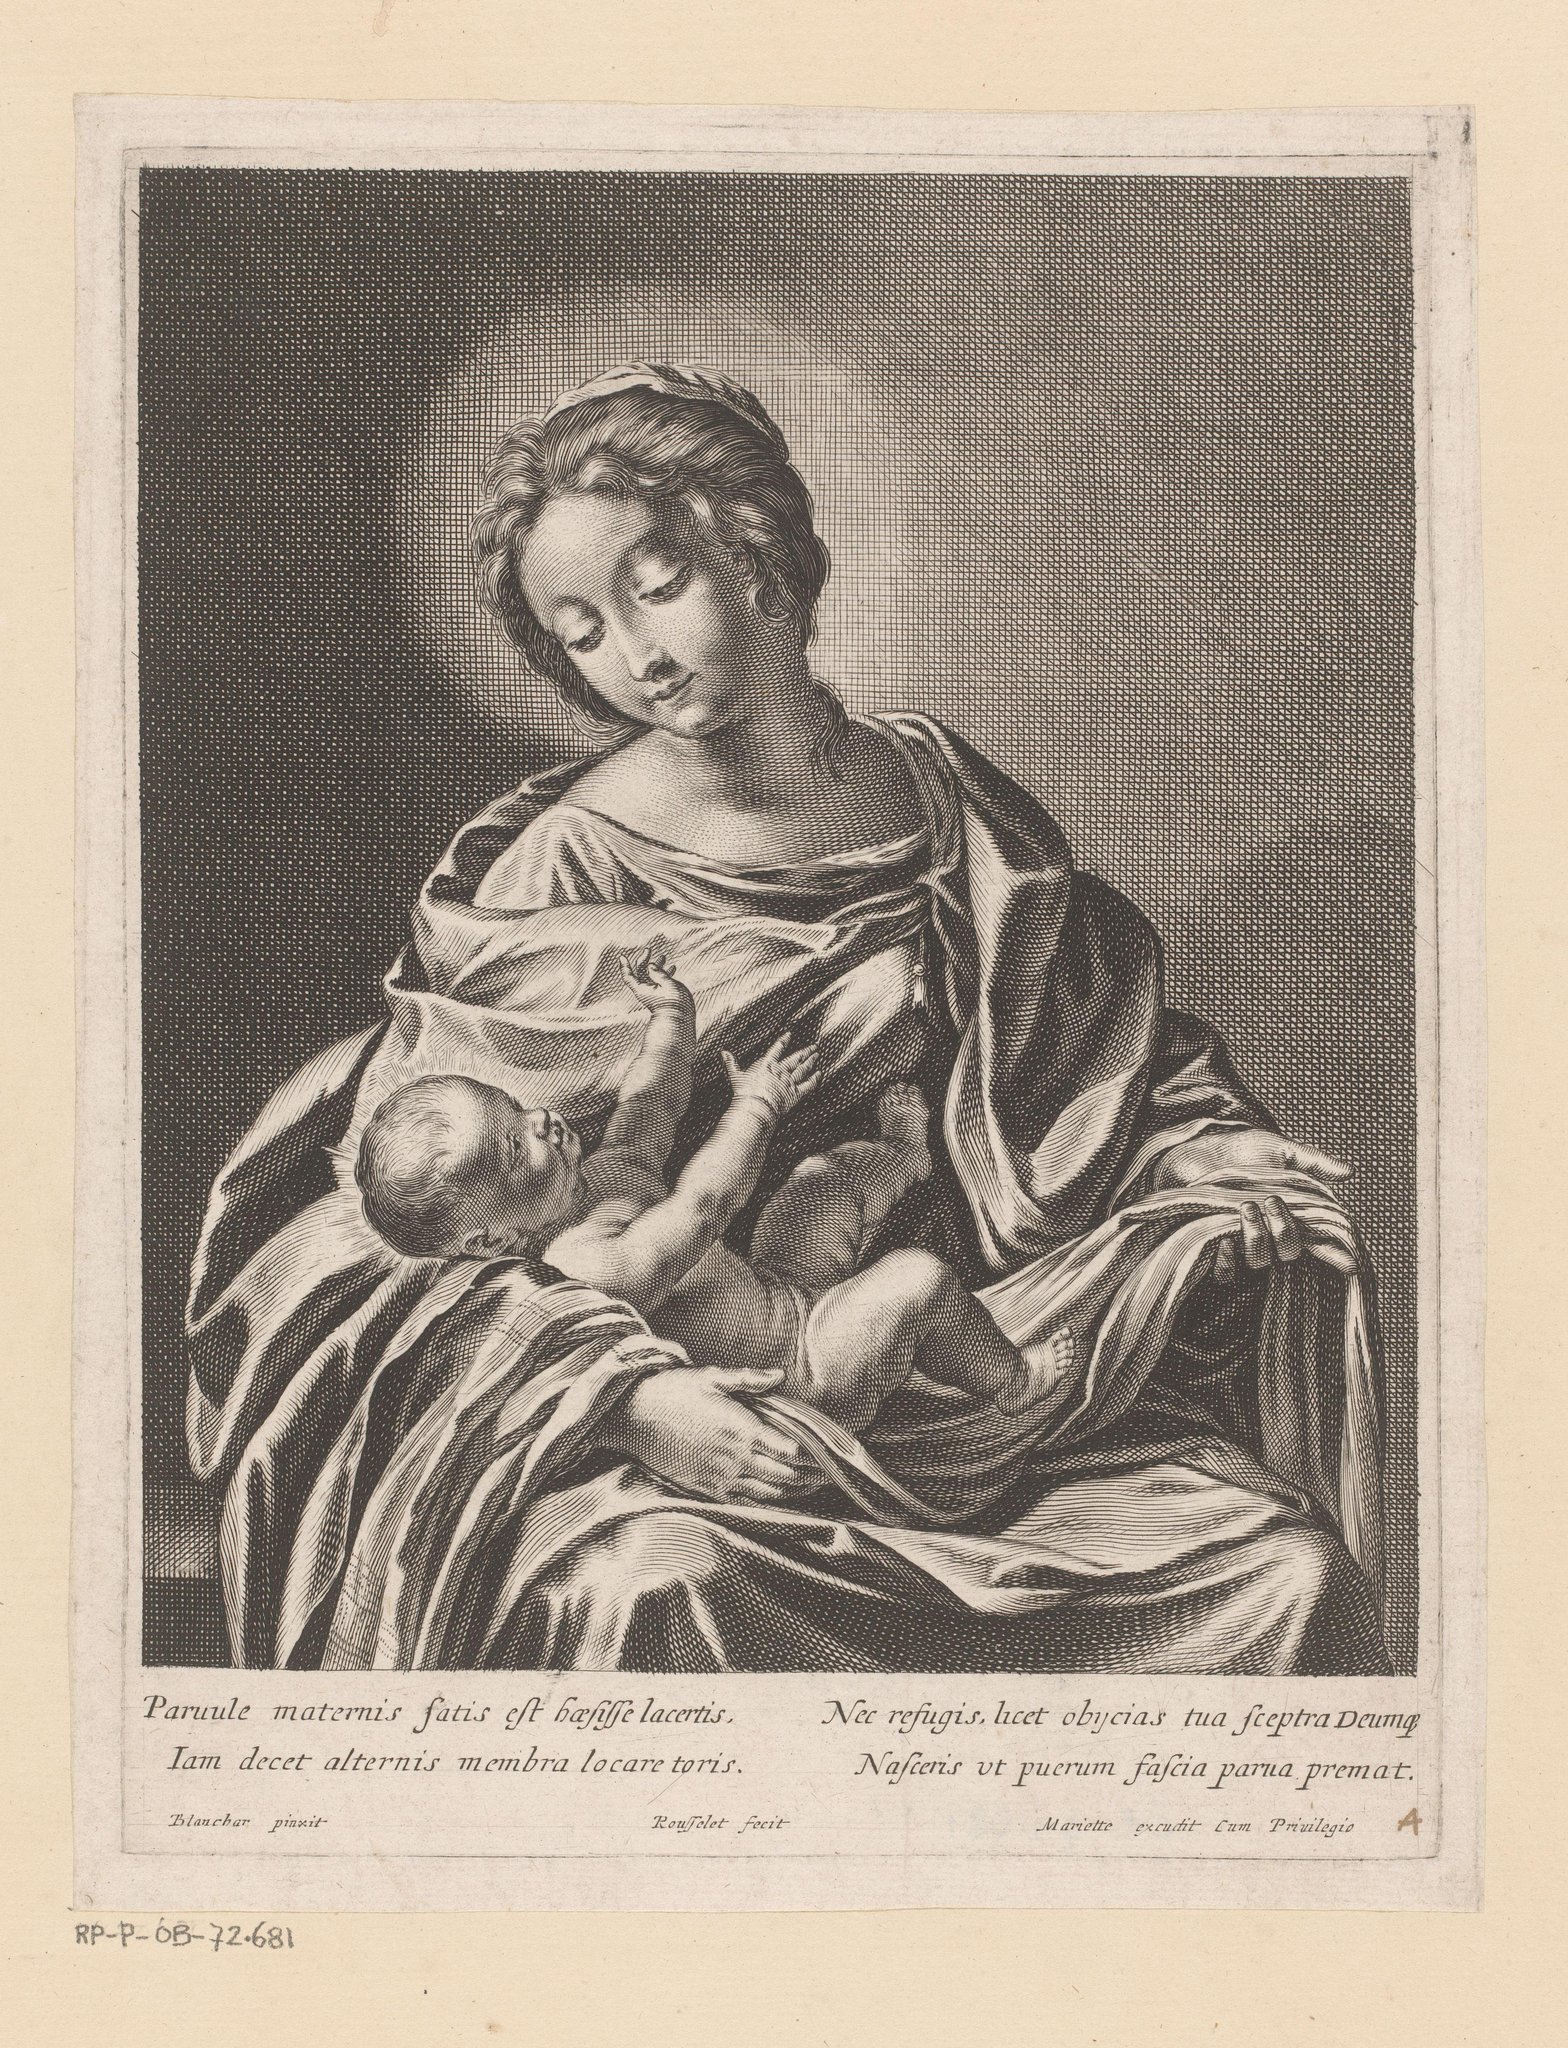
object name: print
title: Maria met kind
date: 1630-1686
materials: paper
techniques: engraving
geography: france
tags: madonna: i.e. mary with the christ-child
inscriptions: collector's mark: Lugt 240